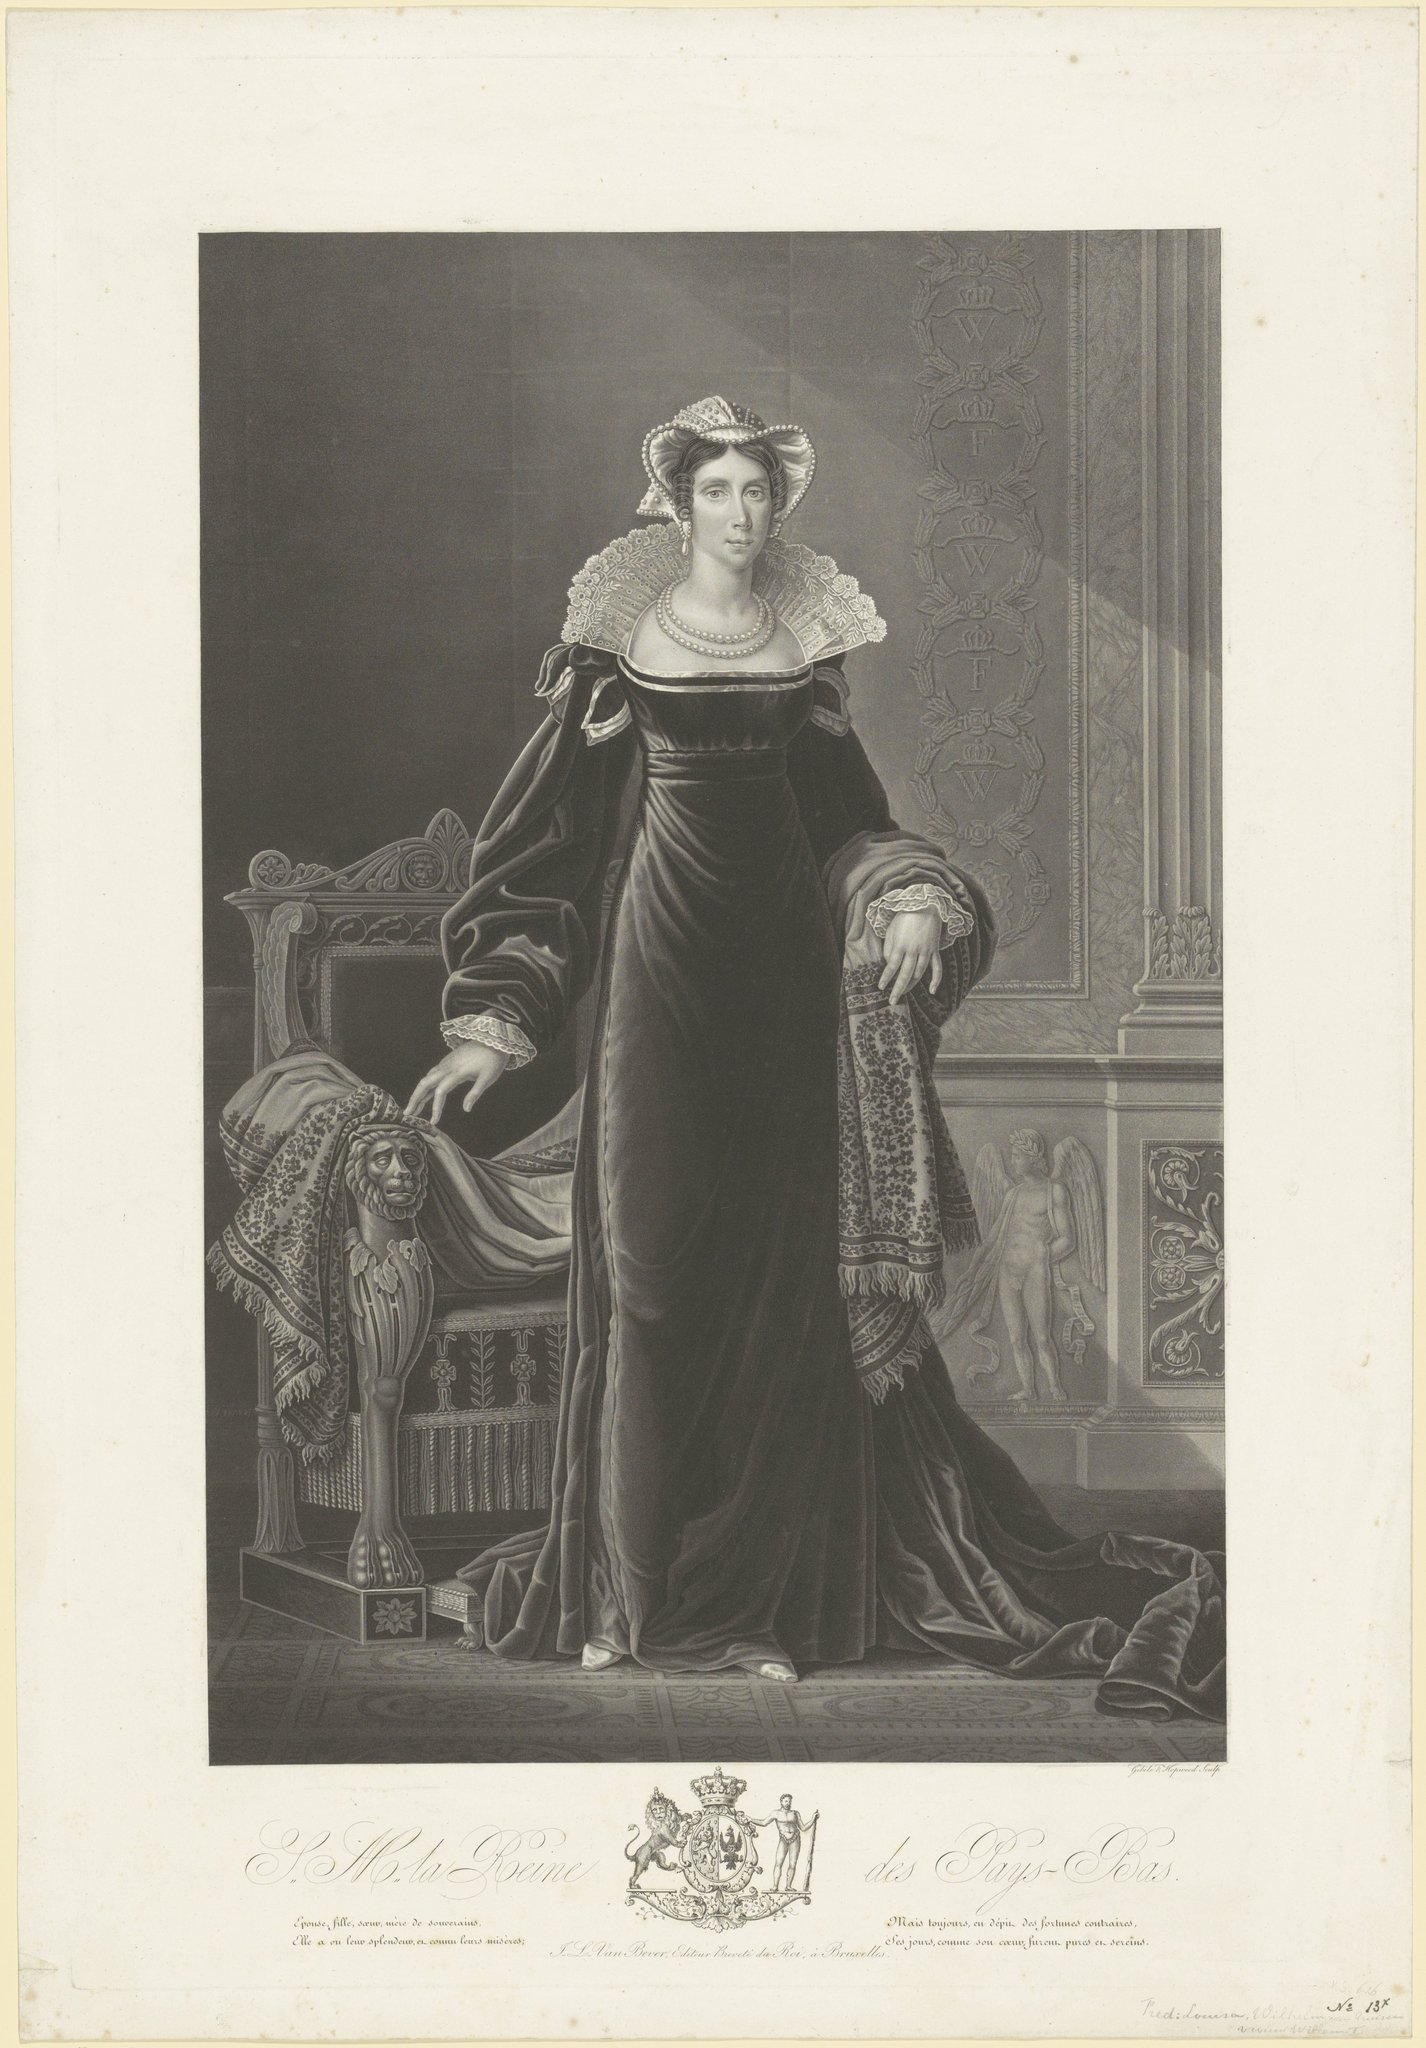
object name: print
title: Portret van Wilhelmina van Pruisen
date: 1815-1830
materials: paper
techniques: aquatint, etching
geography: brussels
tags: berlin, the hague, wilhelmina frederica louisa (koningin der nederlanden)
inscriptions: collector's mark: Lugt 963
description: Portret van Wilhelmina. Ze staat voor een troon. Midden onder haar wapen met een kroon, een leeuw en Hercules. In de ondermarge haar titel en twee kolommen met elk twee regels Franse tekst.